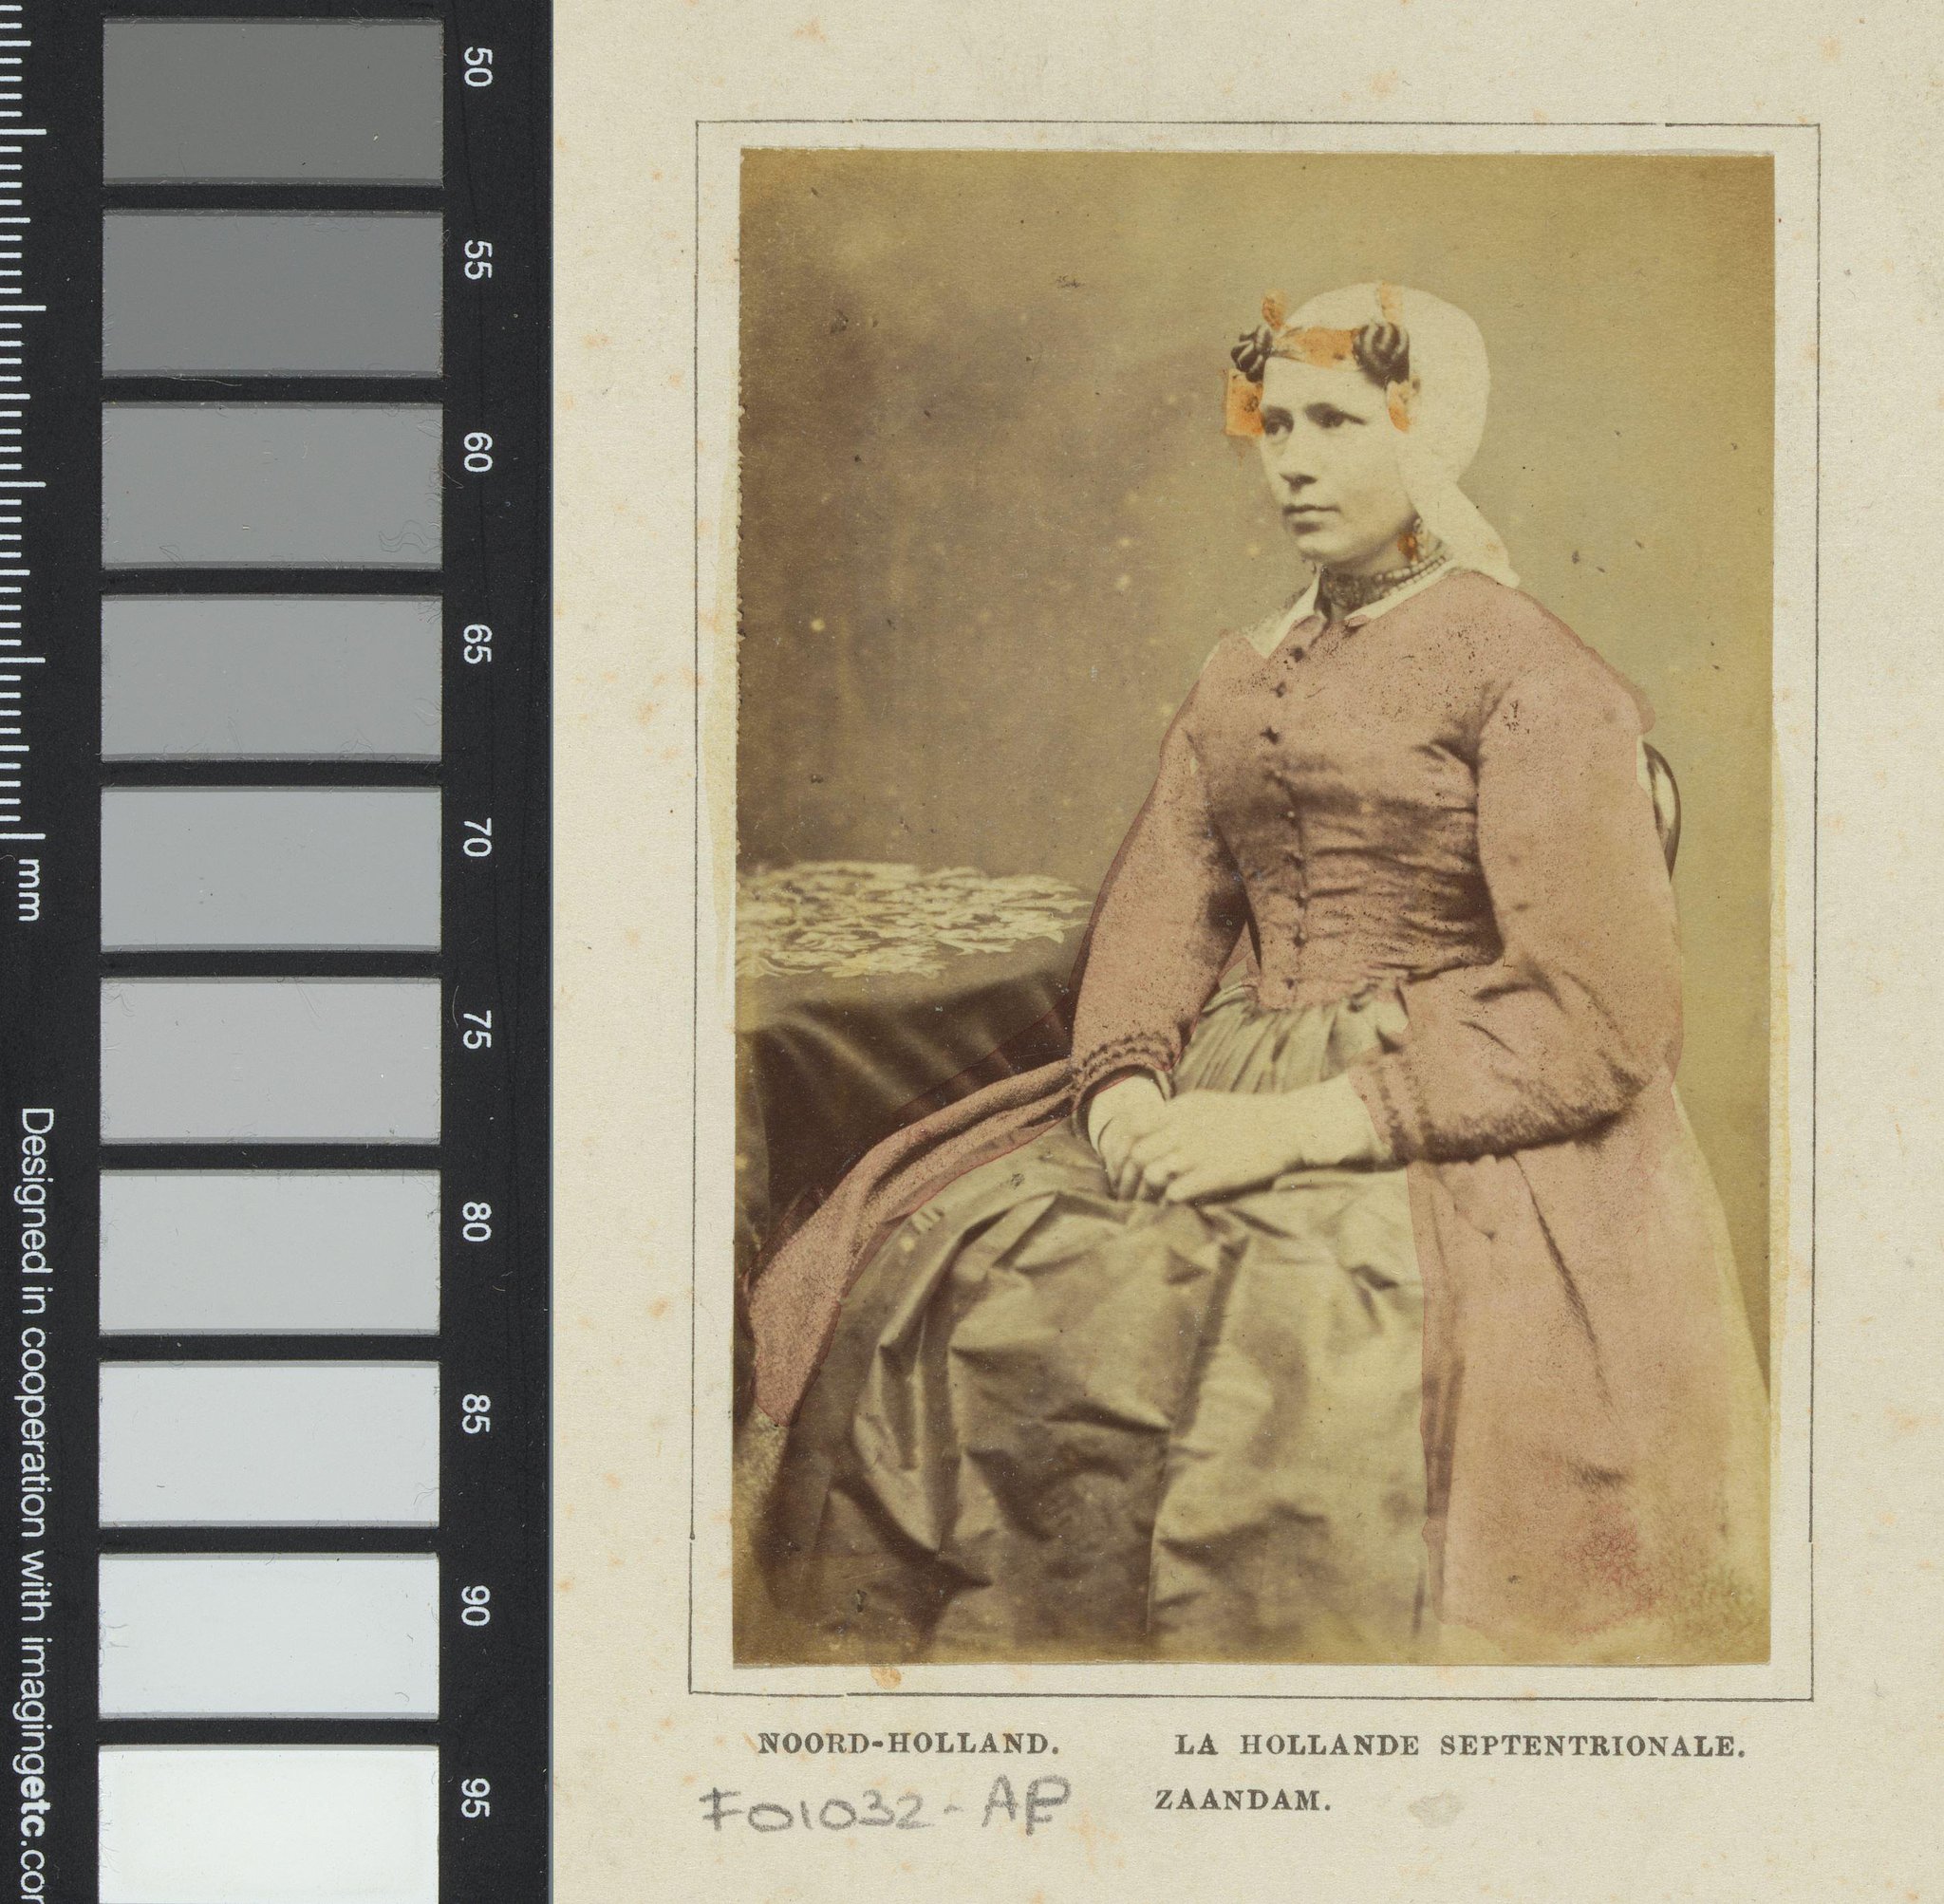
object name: photograph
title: Nederlandsche Kleederdragten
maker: andries jager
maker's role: publisher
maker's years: 1825-1905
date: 1860-1890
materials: cardboard, photographic support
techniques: albumen print, hand coloring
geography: amsterdam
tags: folk costume, regional costume (+ women's clothes), historical persons - bb - woman, europeans (with name), netherlands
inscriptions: inscription: ‘Uitgave van A. JAGER, Water 110 te Amsterdam.’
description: Deze foto maakt deel uit van een omslag met 48 foto's op 12 bladen.